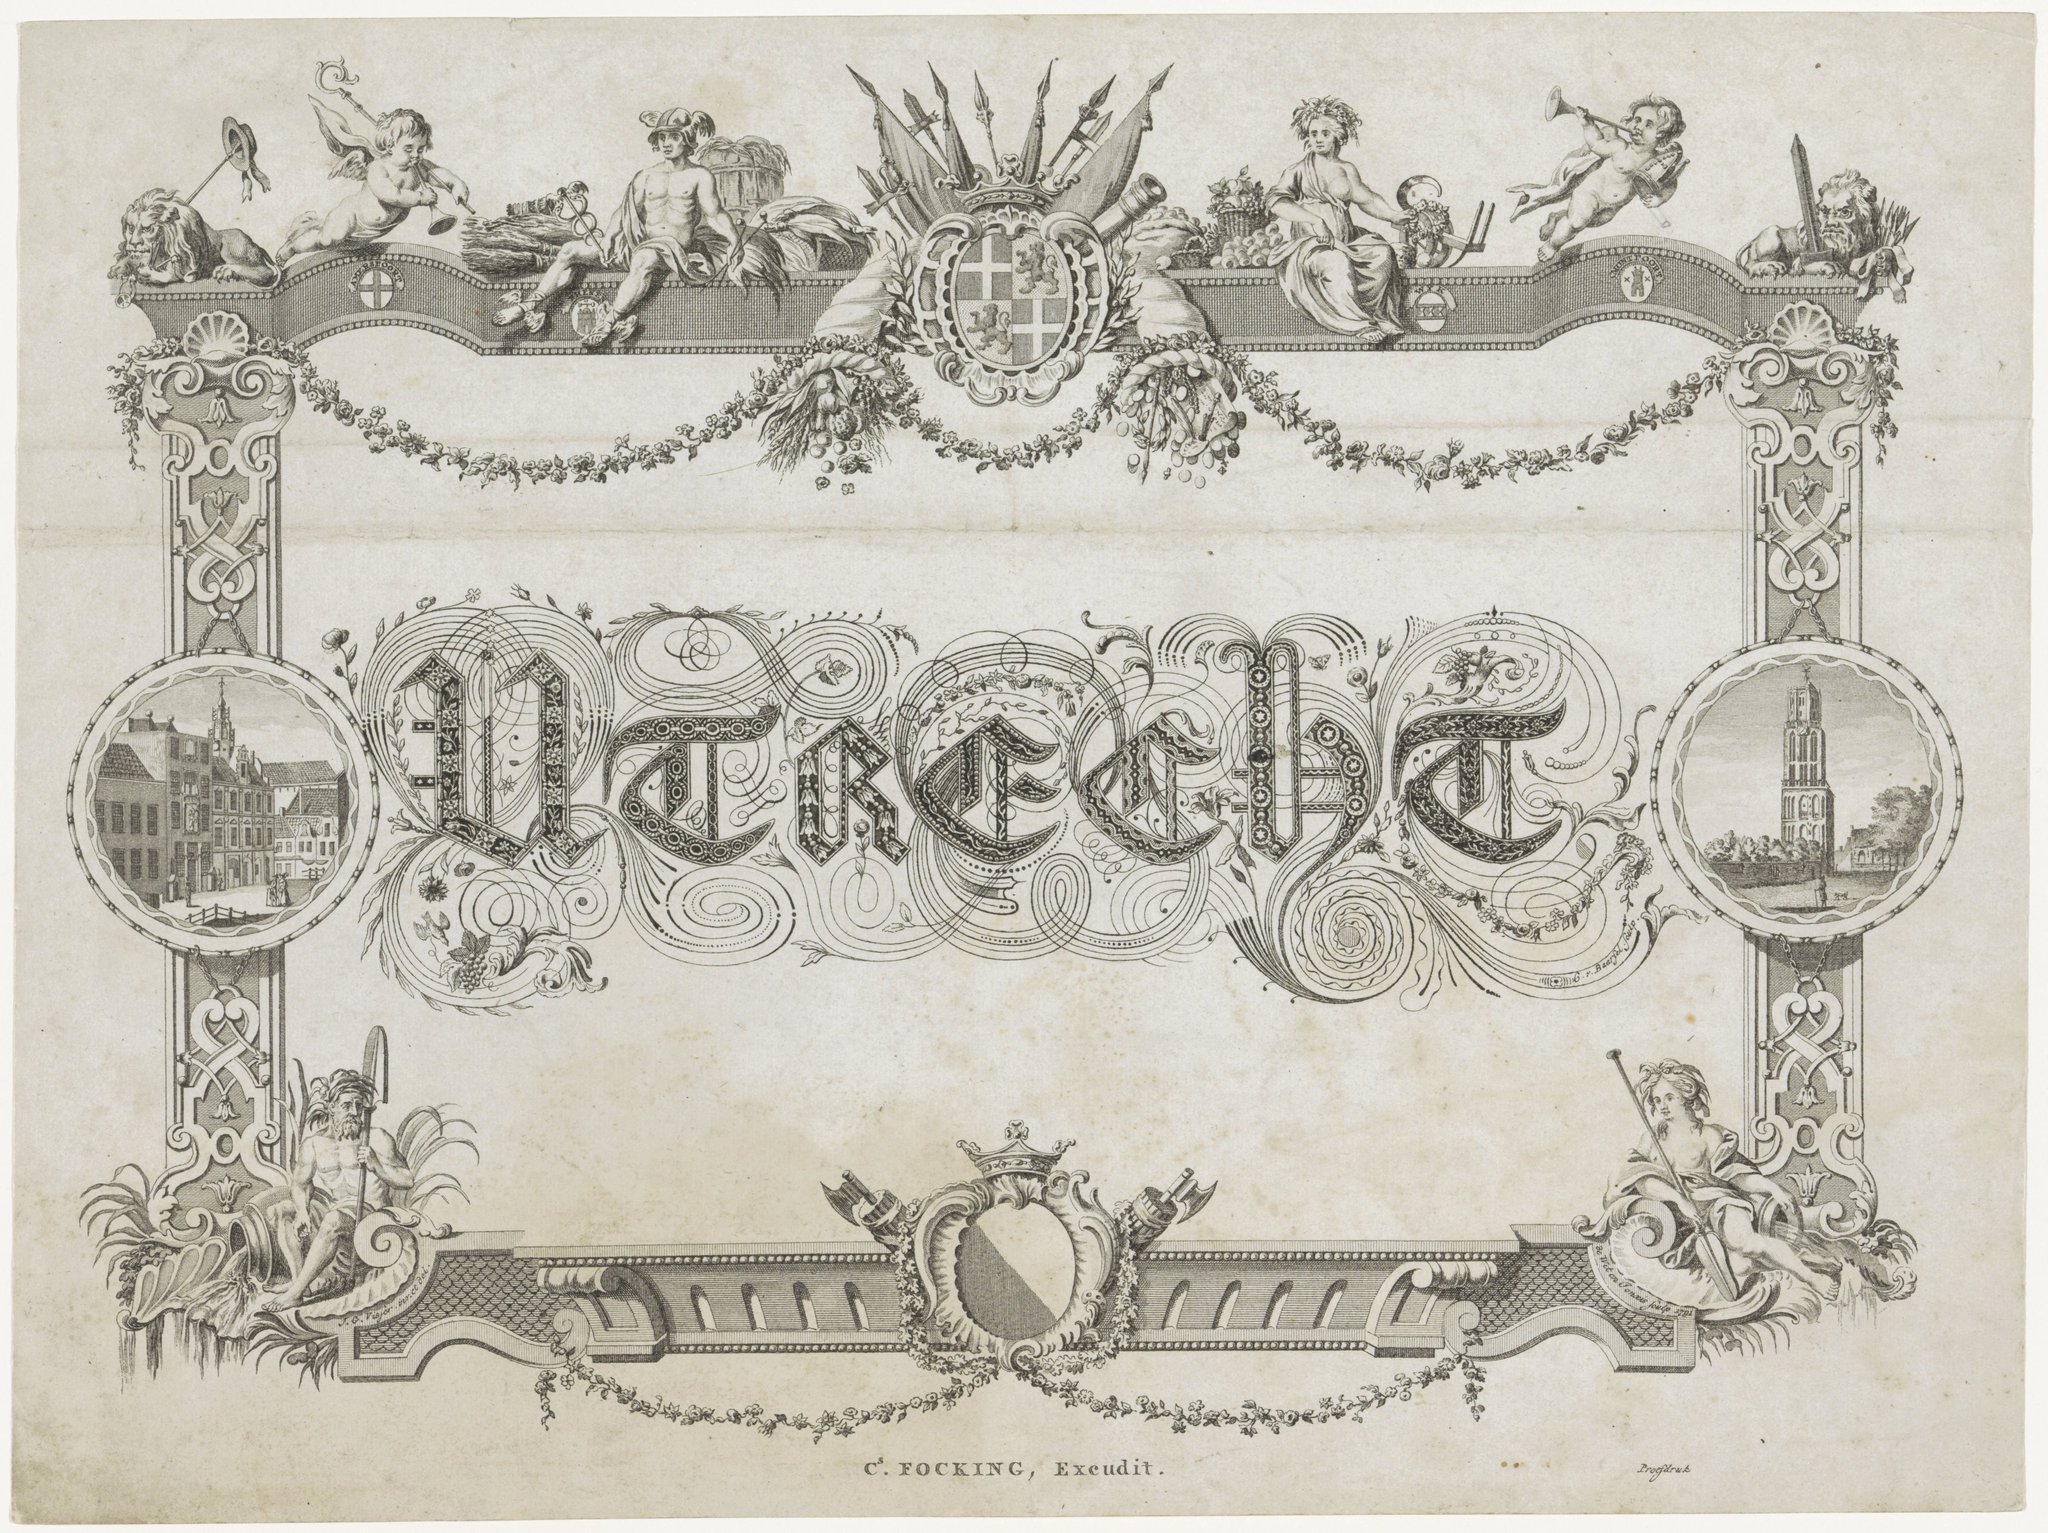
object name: calligraphy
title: Kalligrafie van de provincie Utrecht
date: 1791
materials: paper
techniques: calligraphy, engraving, etching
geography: amsterdam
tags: calligraphy, utrecht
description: Kalligrafie van de naam van de provincie Utrecht. Binnen een kader met het provinciewapen, allegorische en mythologische figuren, wapens van de belangrijkste steden en twee topografische gezichten. Hier: Stadhuis en Domtoren te Utrecht. Onderdeel van een serie van zeven kalligrafieën van de provincies. Op de achterzijde zijn met potlood de contouren om enkele handen getrokken.